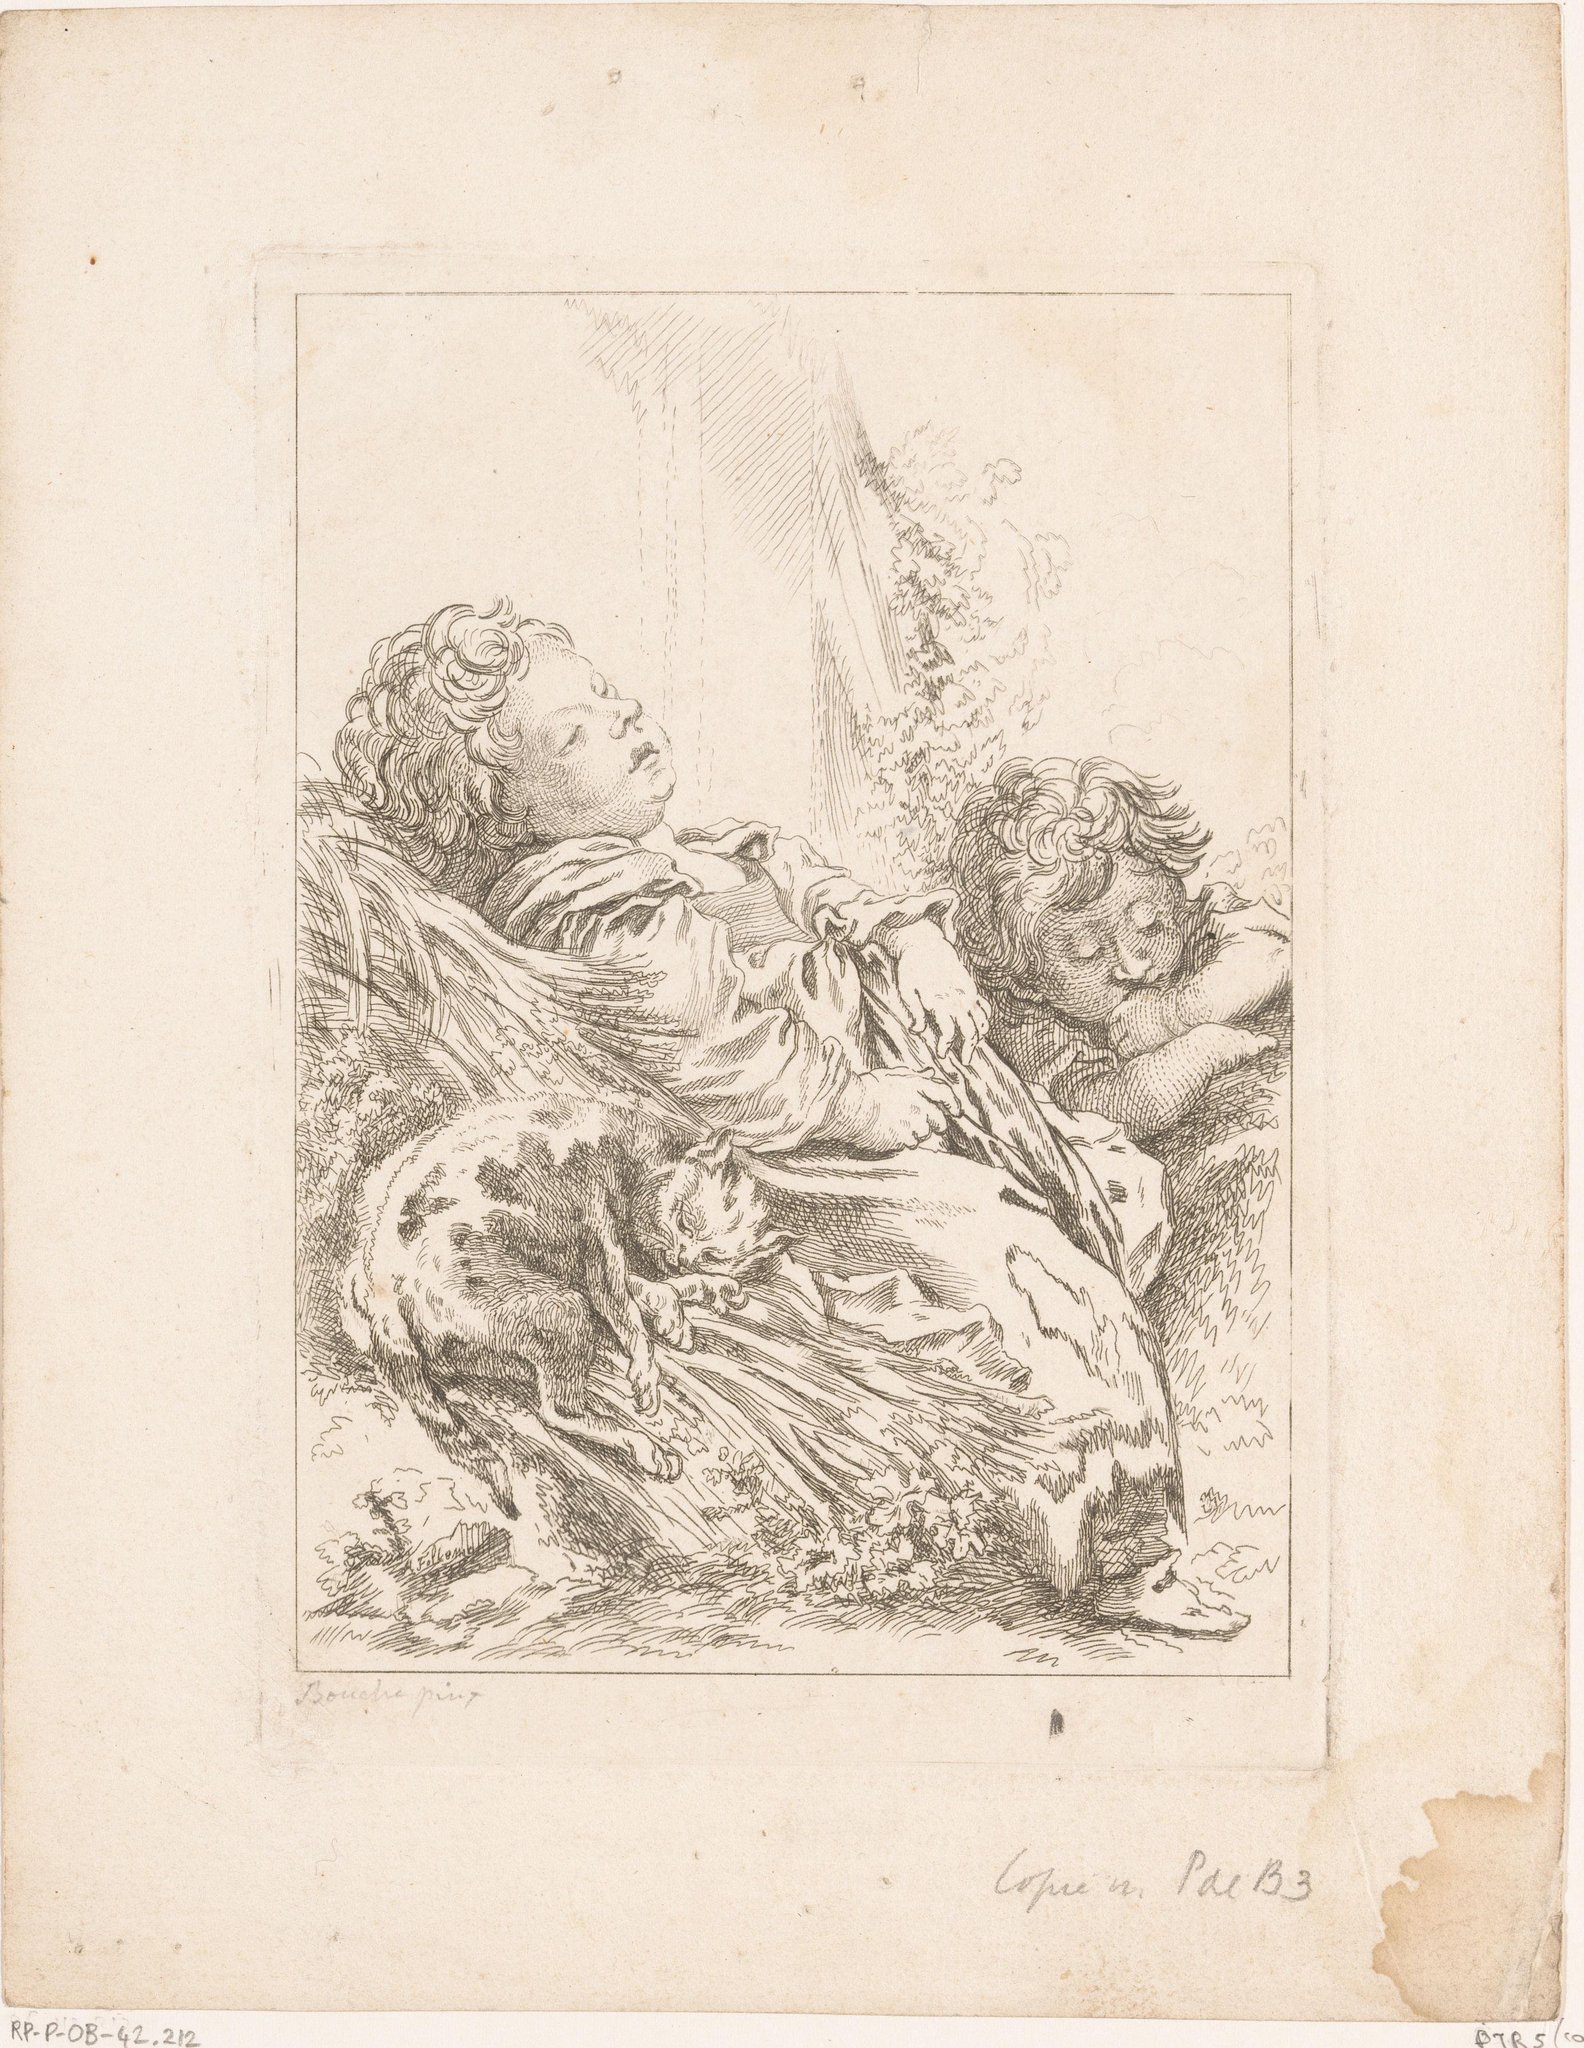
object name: print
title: Slapende kleuters met kat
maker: anna folkema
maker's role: draughtsman, print maker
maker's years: 1695-1768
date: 1705-1768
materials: paper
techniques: etching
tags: cat, sleeping on the ground, tot, toddler ~ the ages of man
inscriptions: collector's mark: Lugt 2228